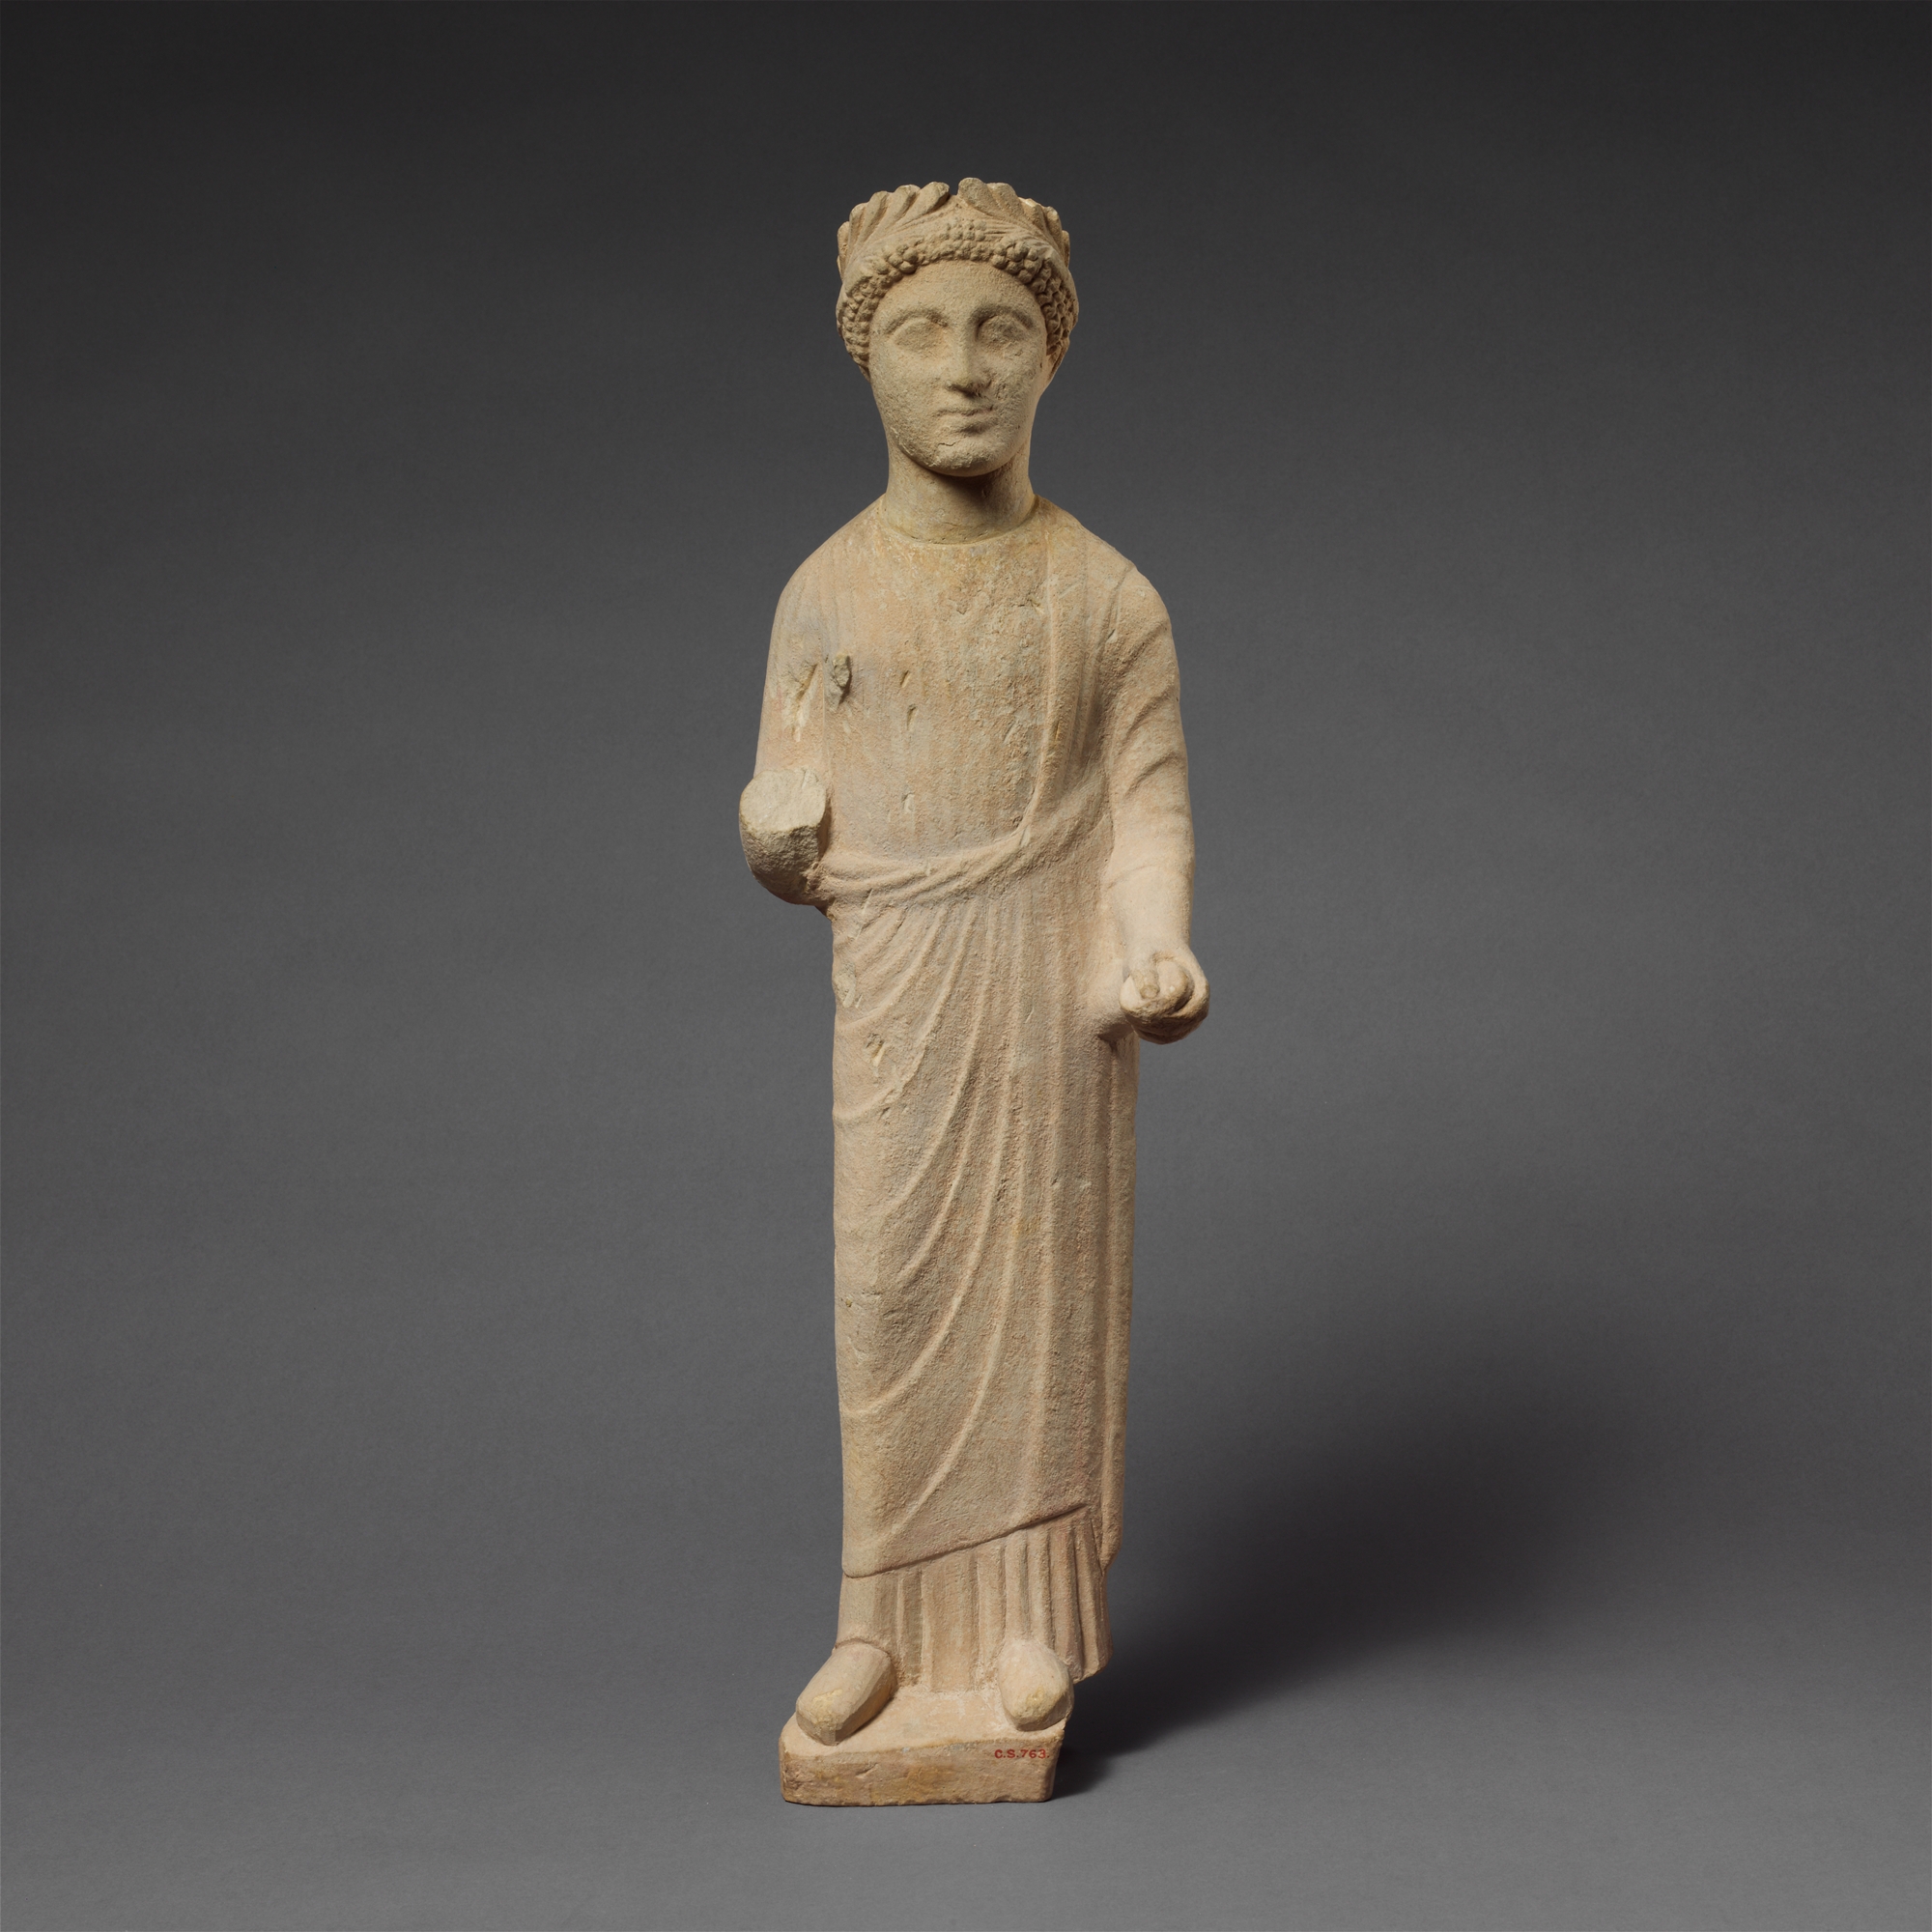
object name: statue of a votary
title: Limestone statuette of a beardless male votary with a wreath of leaves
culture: cypriot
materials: limestone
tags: men,leaves,wreaths